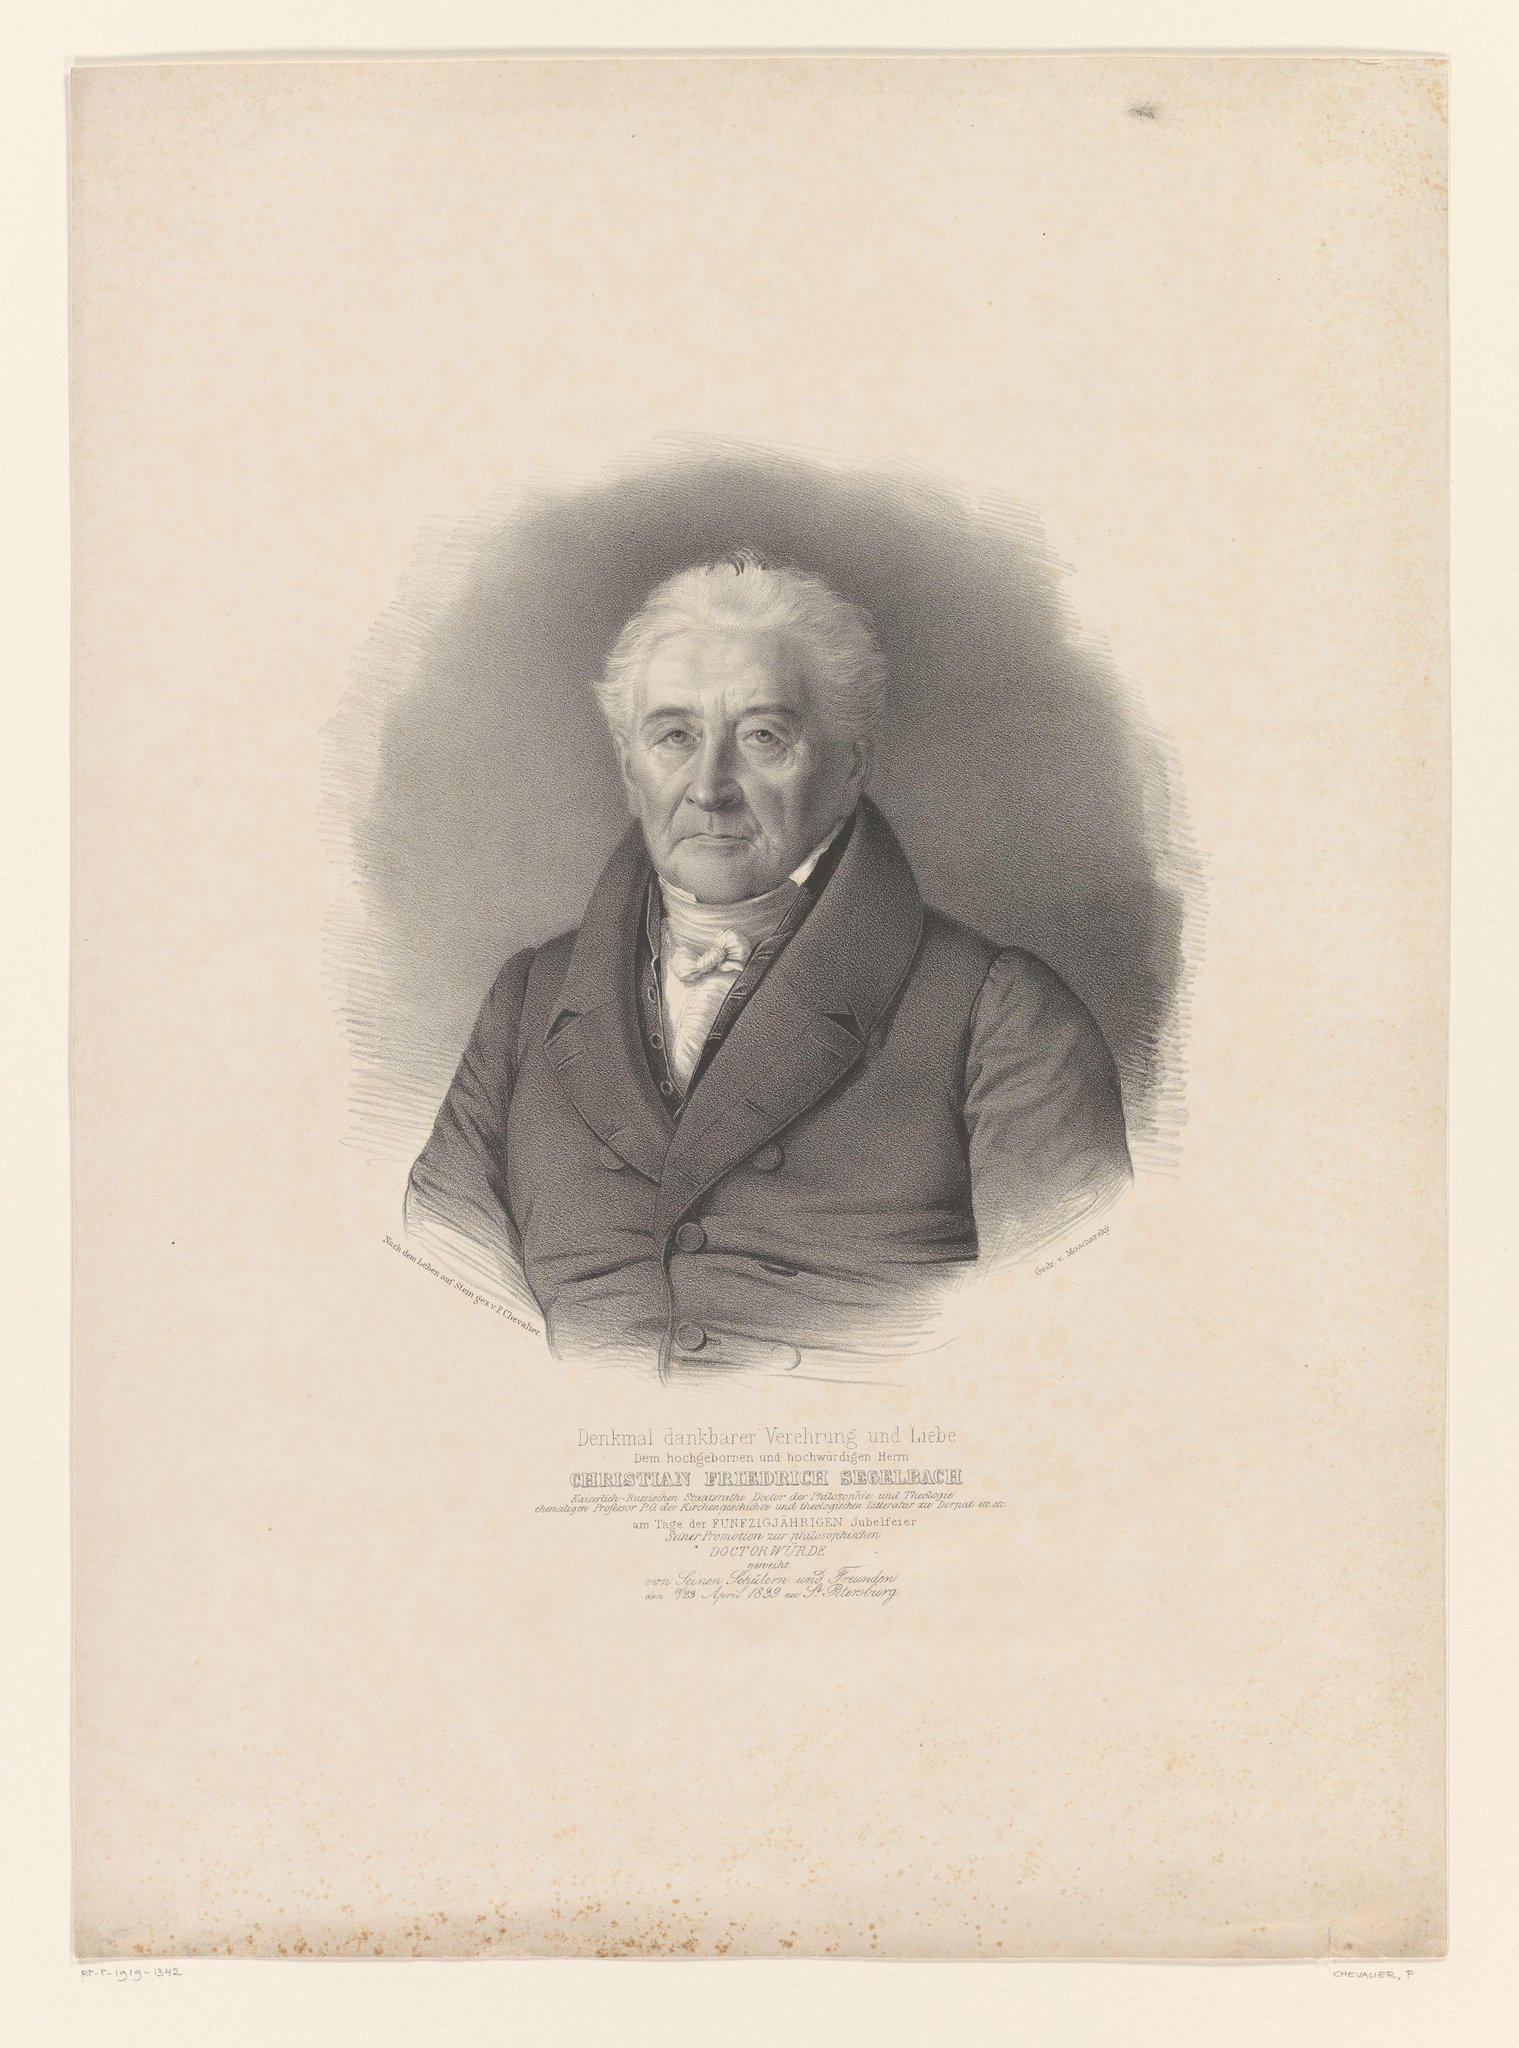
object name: print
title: Denkmal dankbare Verehrung und Liebe (...) Christian Friedrich Segelbach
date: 1839-1850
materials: paper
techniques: lithograph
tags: adult man, historical persons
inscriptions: collector's mark: Lugt 2228